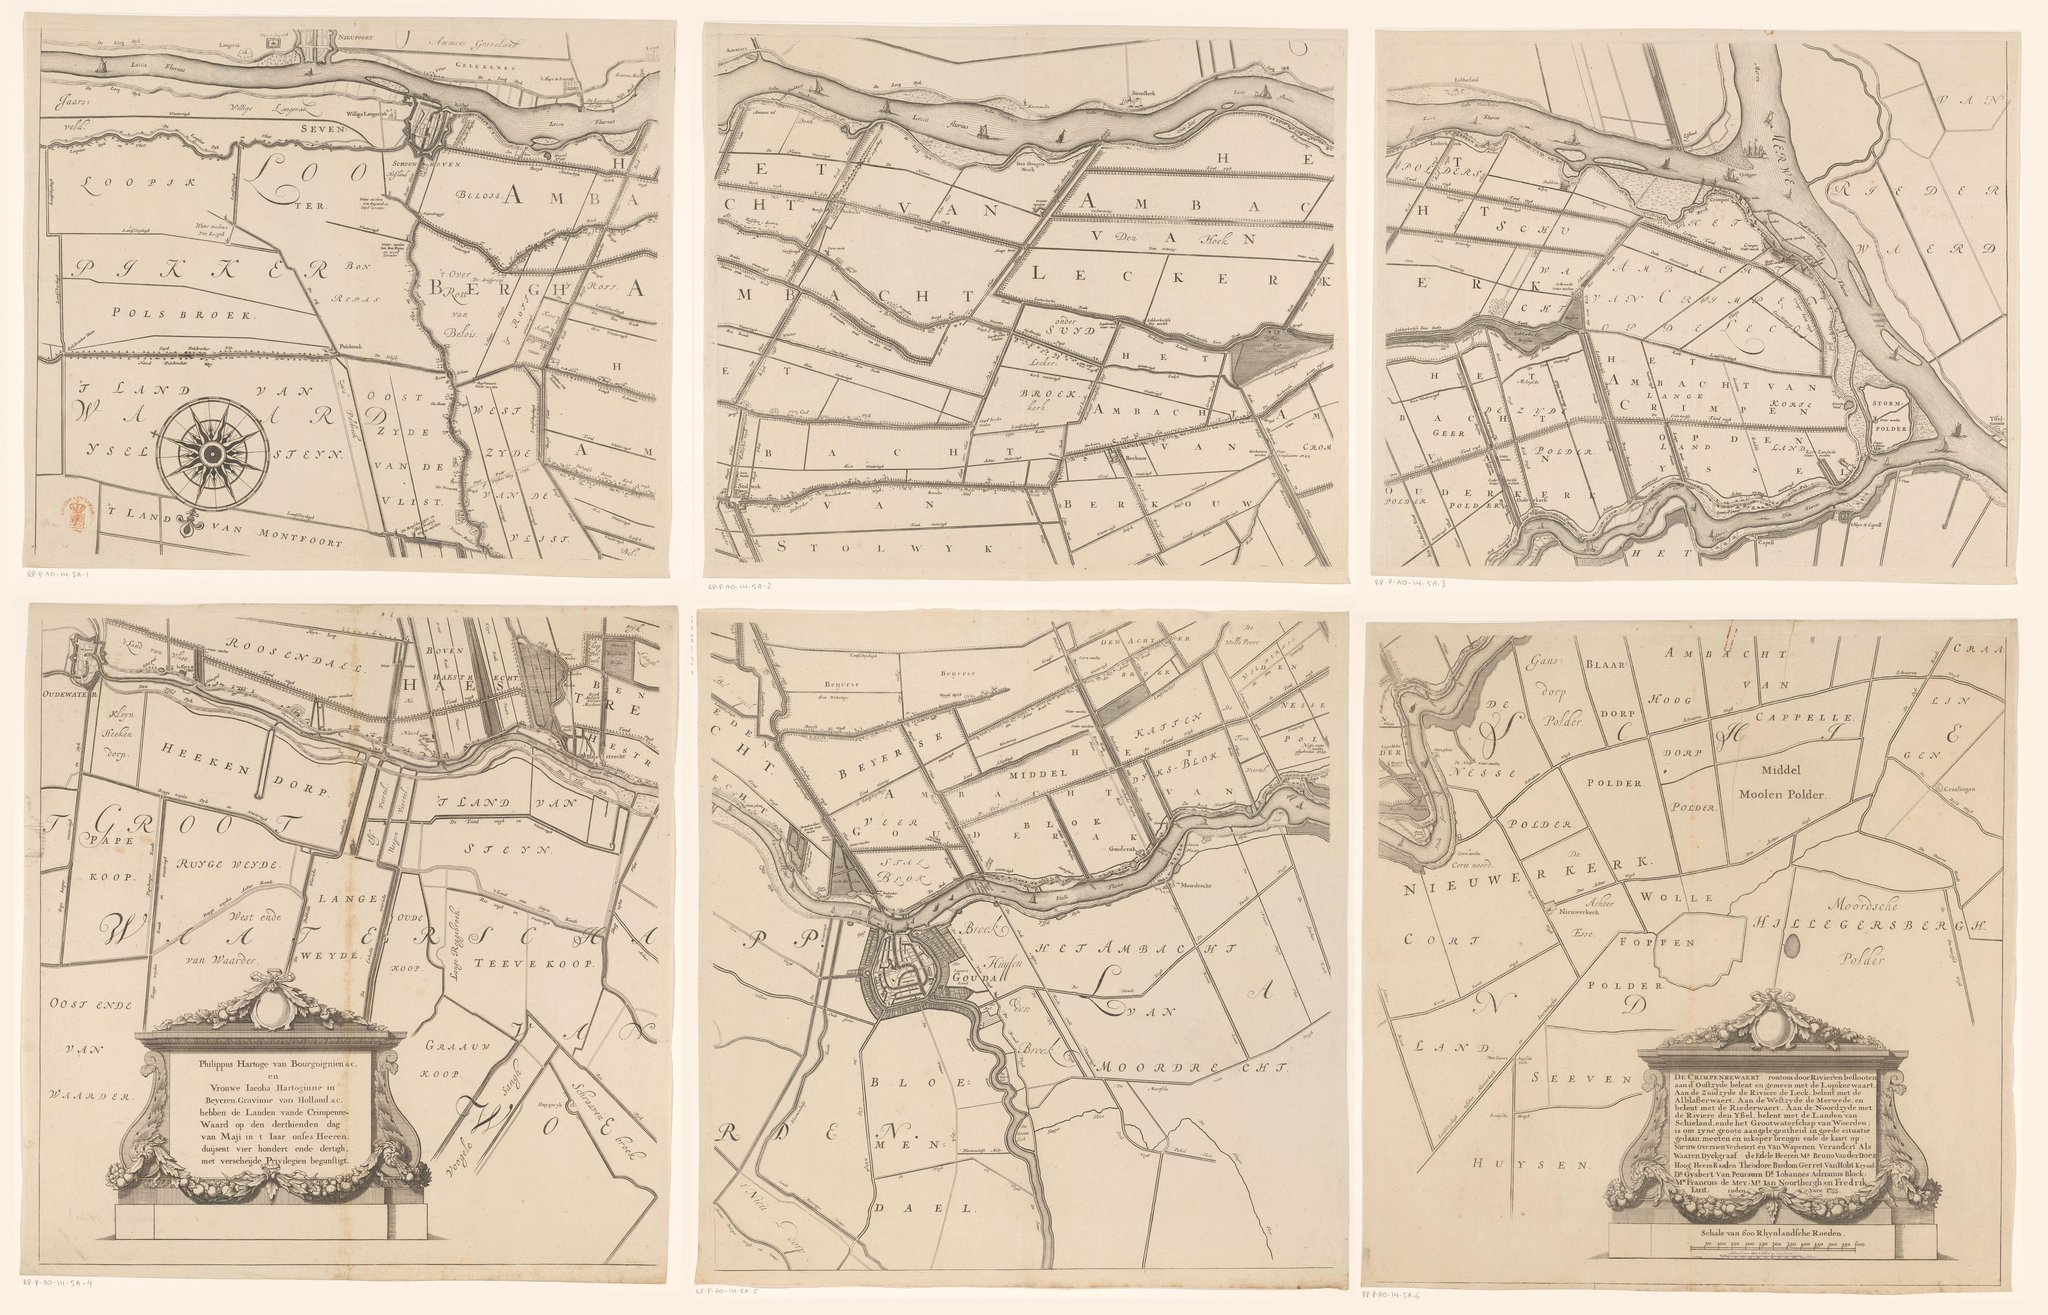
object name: print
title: Kaart van het Hoogheemraadschap van de Krimpenerwaard, bestaande uit zes delen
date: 1683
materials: ink, paper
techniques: engraving, etching, pen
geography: the hague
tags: maps of separate countries or regions, maps of cities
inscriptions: collector's mark: Lugt 19, collector's mark: Lugt 19, inscription: ‘Schaal van 168, 17 ellen op den duim’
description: Kaart van het Hoogheemraadschap van de Krimpenerwaard. Linksonder een cartouche met informatie en rechtsonder een cartouche met informatie en een schaalstok: Schale van 600 Rhynlandsche roeden. De bijhorende wapenrand ontbreekt.